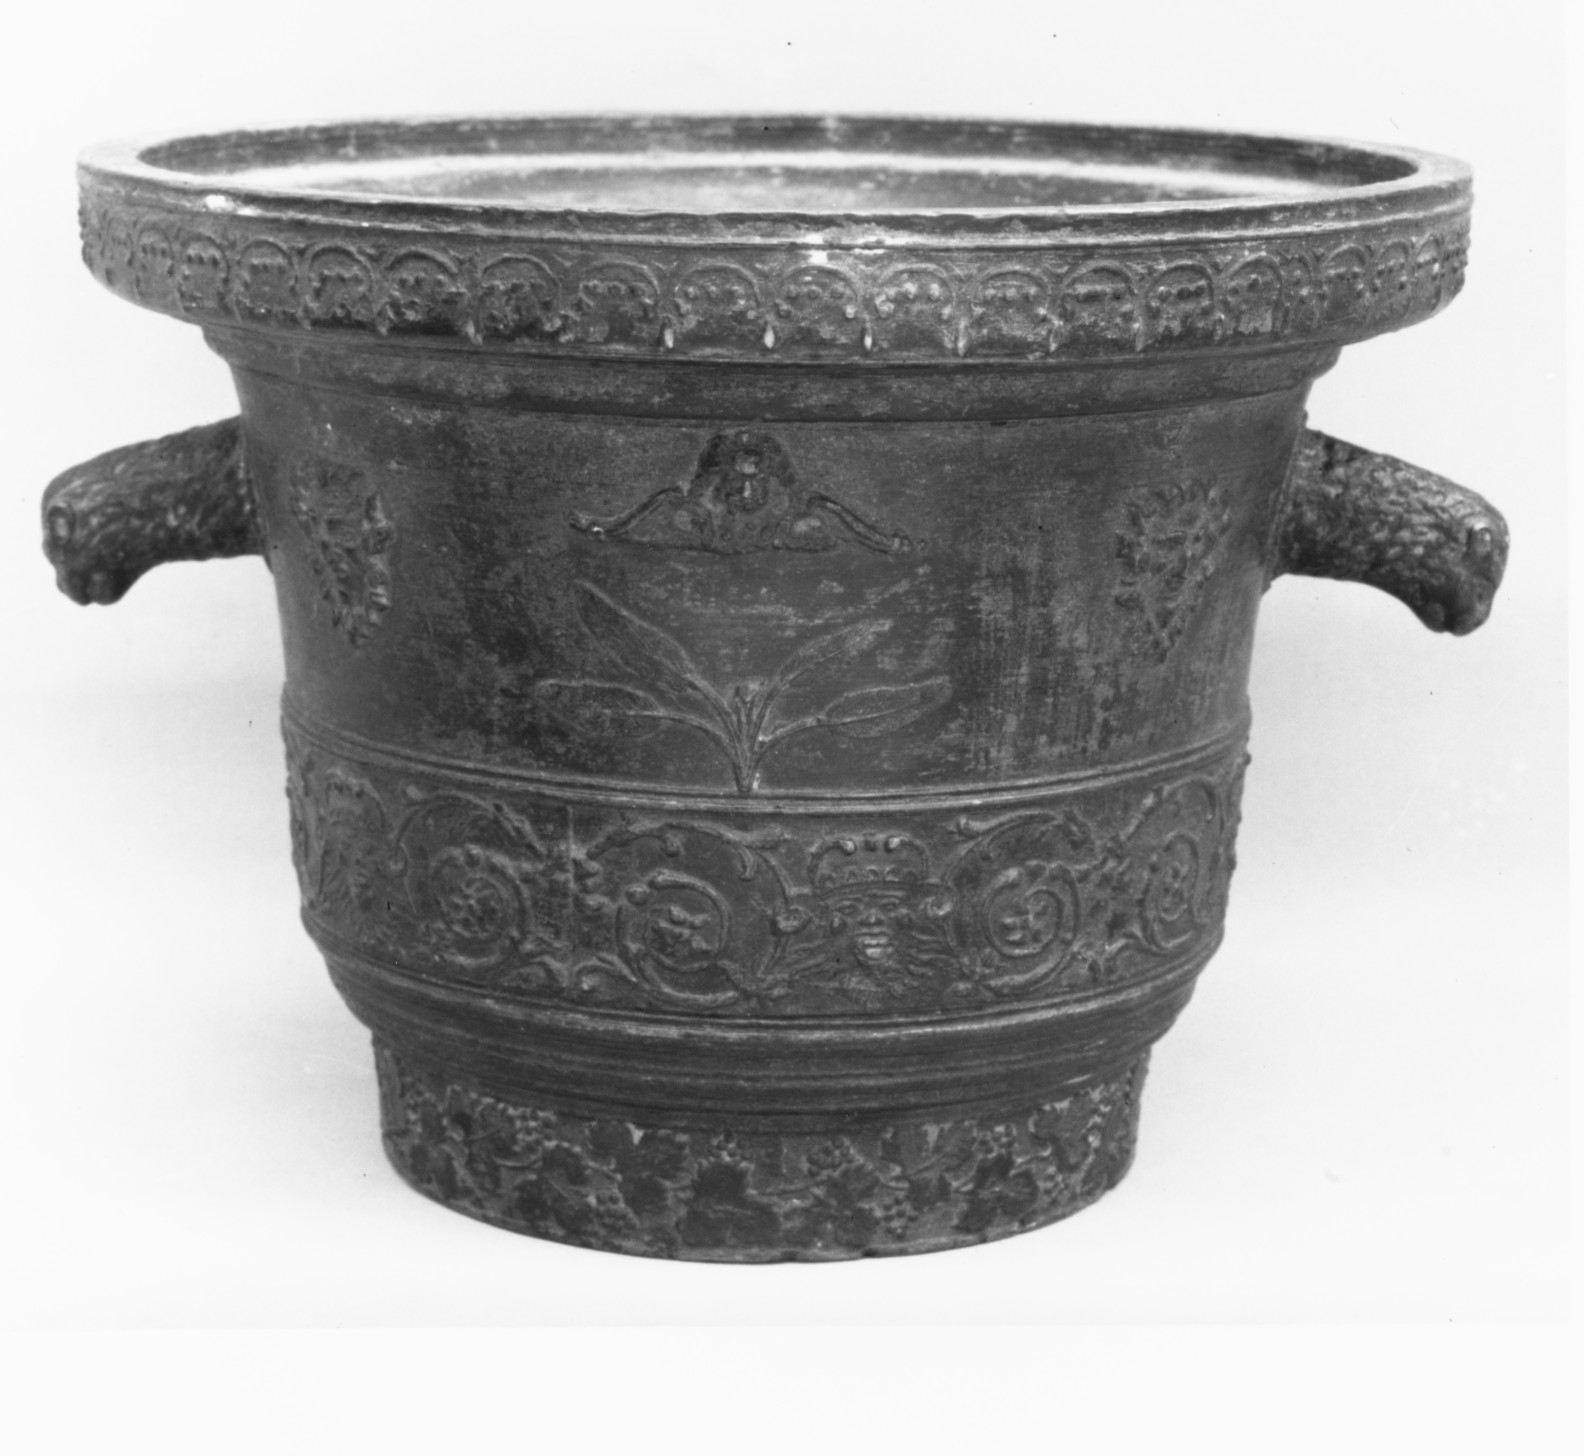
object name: mortar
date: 1501-1600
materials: bronze